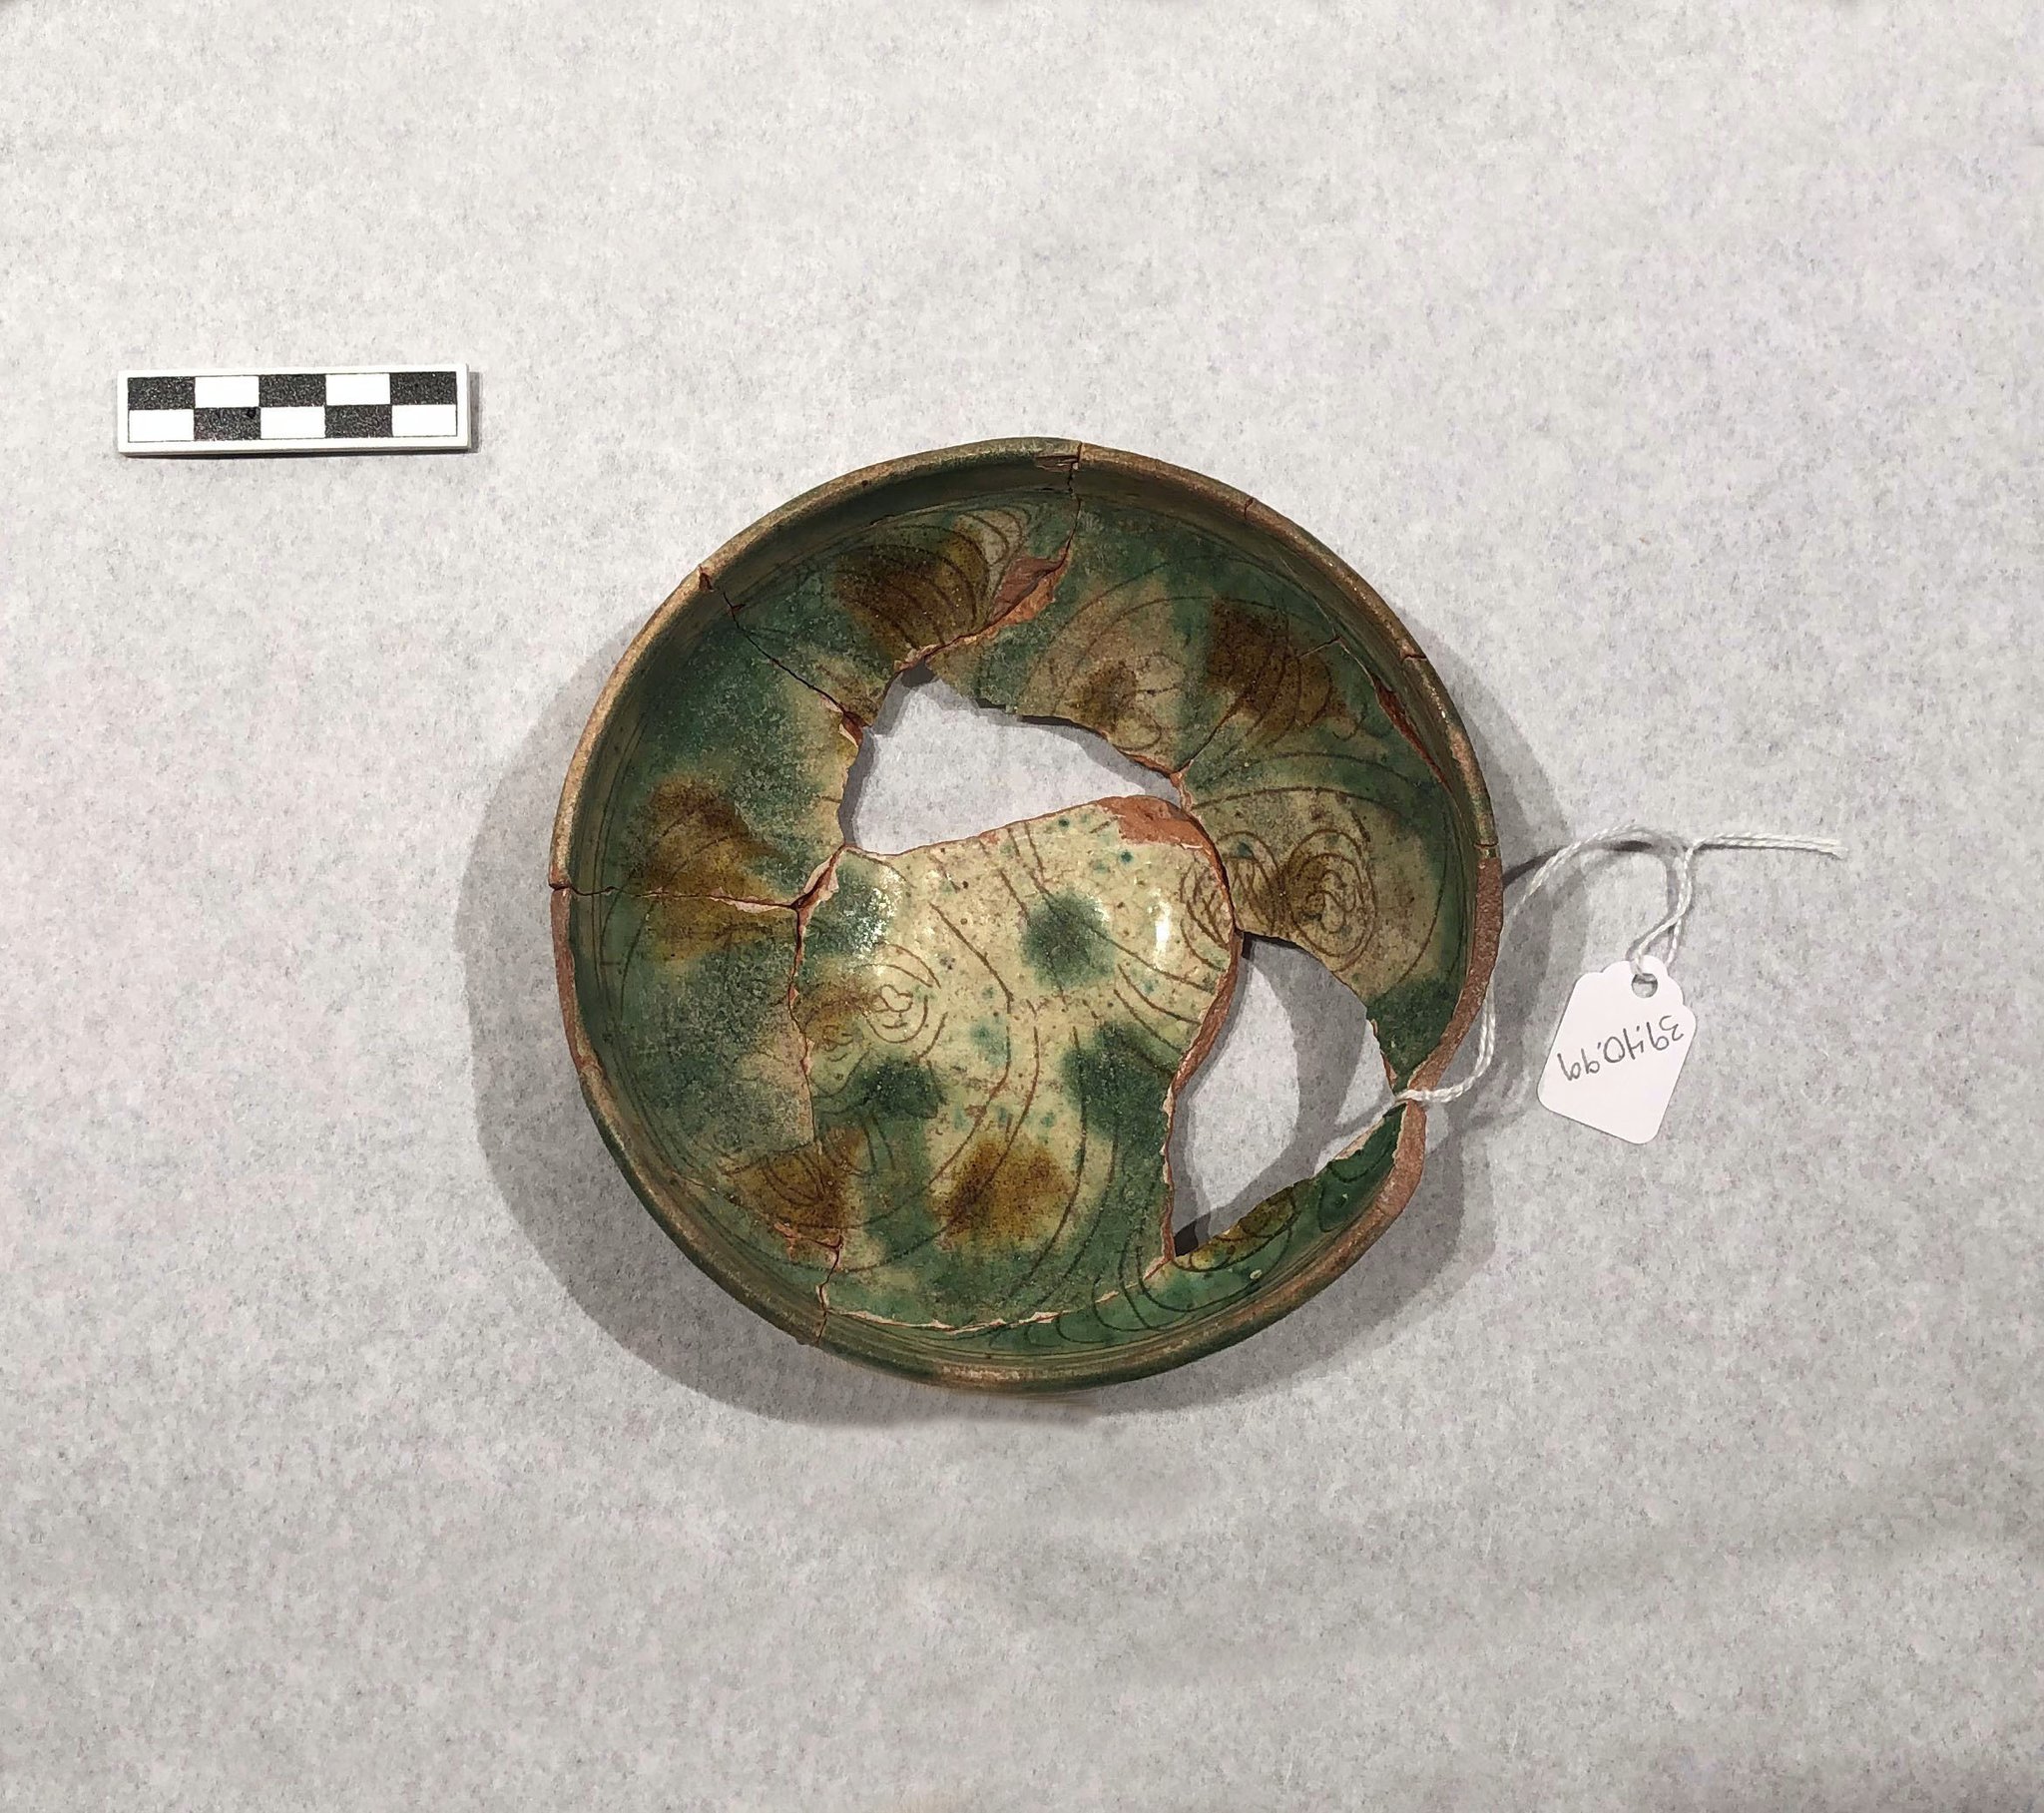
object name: bowl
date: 801-1000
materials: earthenware, glaze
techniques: incising, polychrome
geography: iran